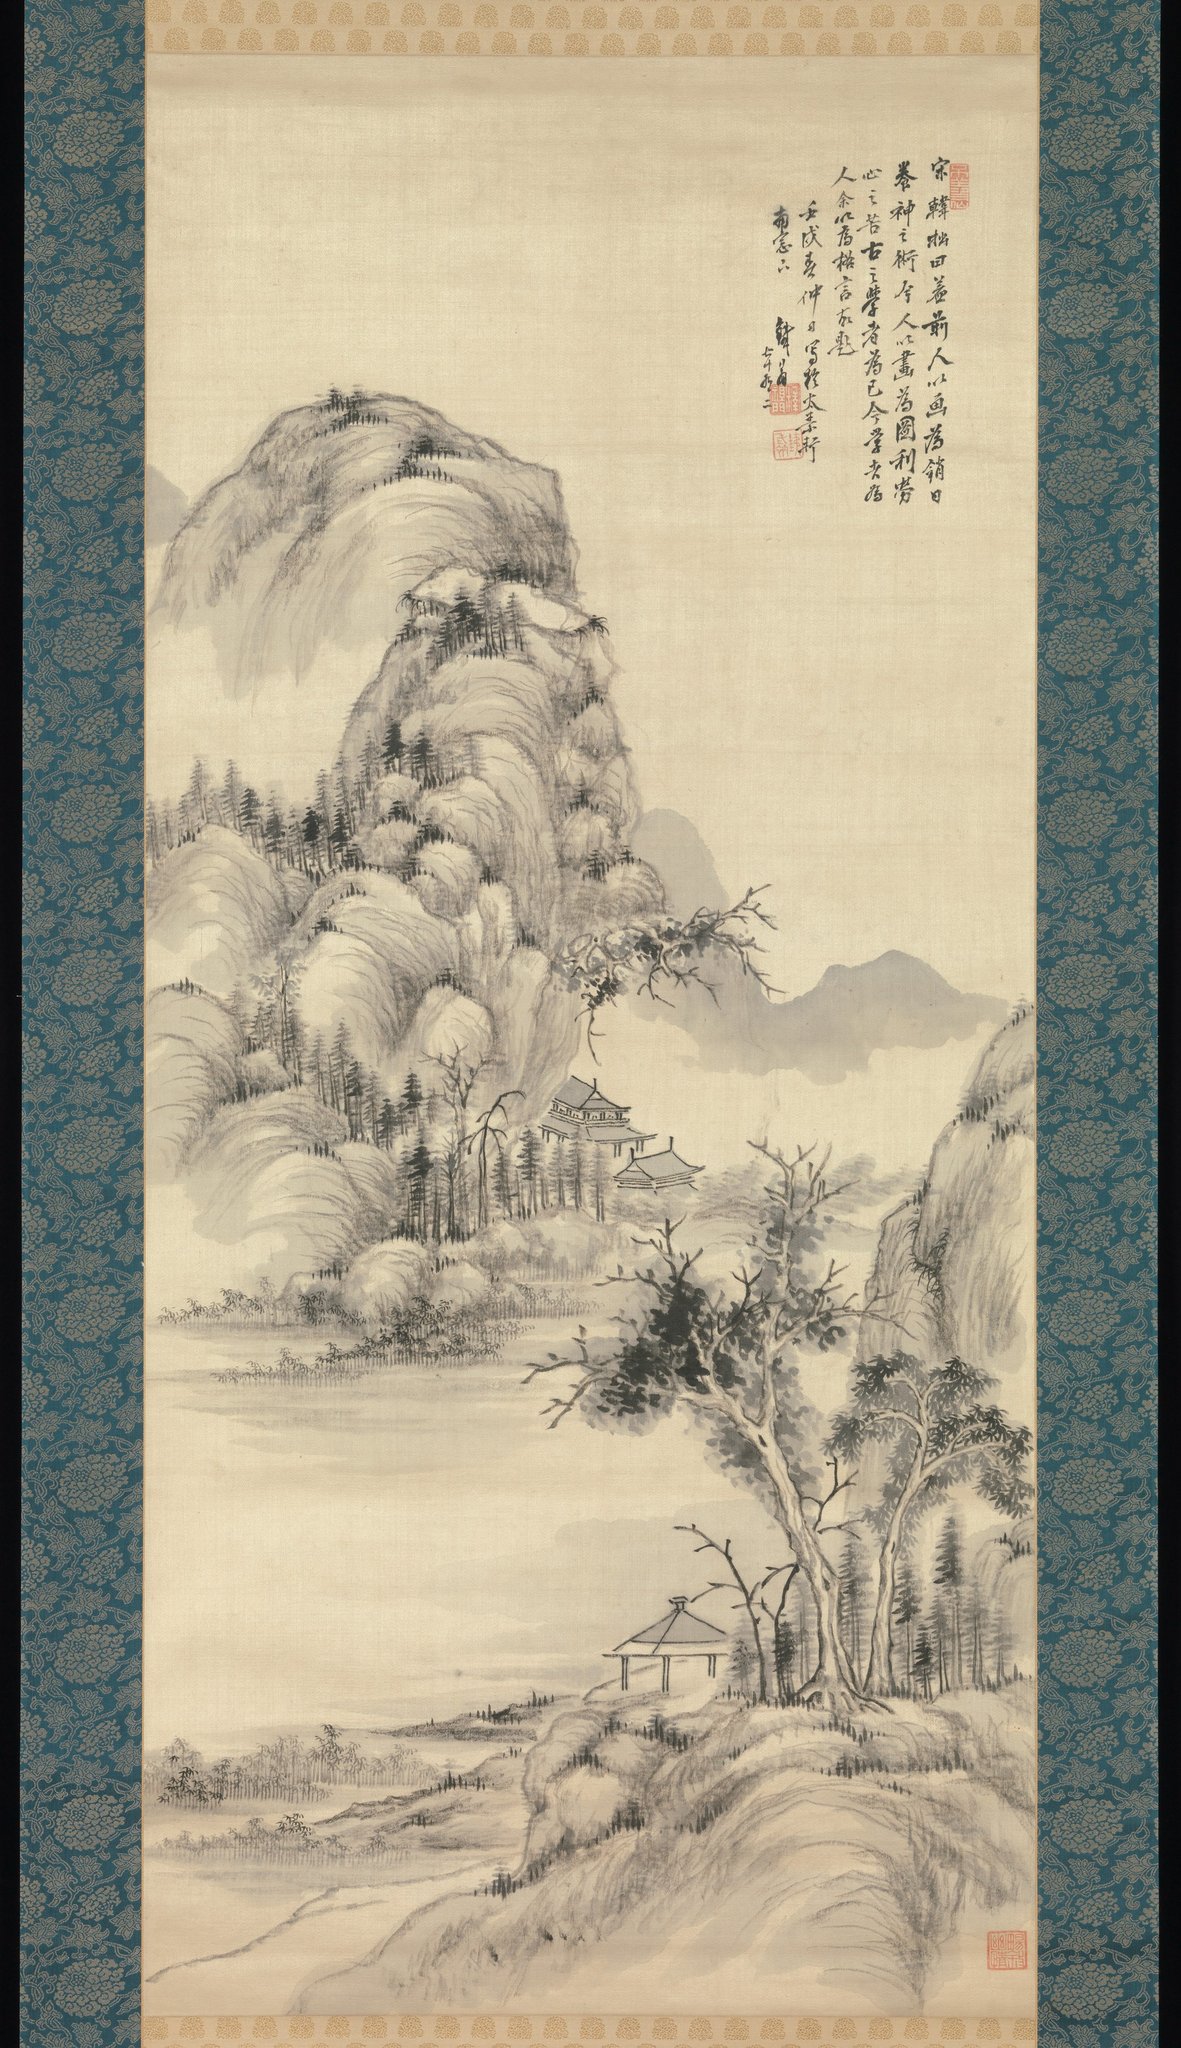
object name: hanging scroll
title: Autumn Landscape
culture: japanese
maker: hidaka tetsuo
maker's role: artist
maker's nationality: japanese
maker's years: 1791-1875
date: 1862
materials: ink, textile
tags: landscapes